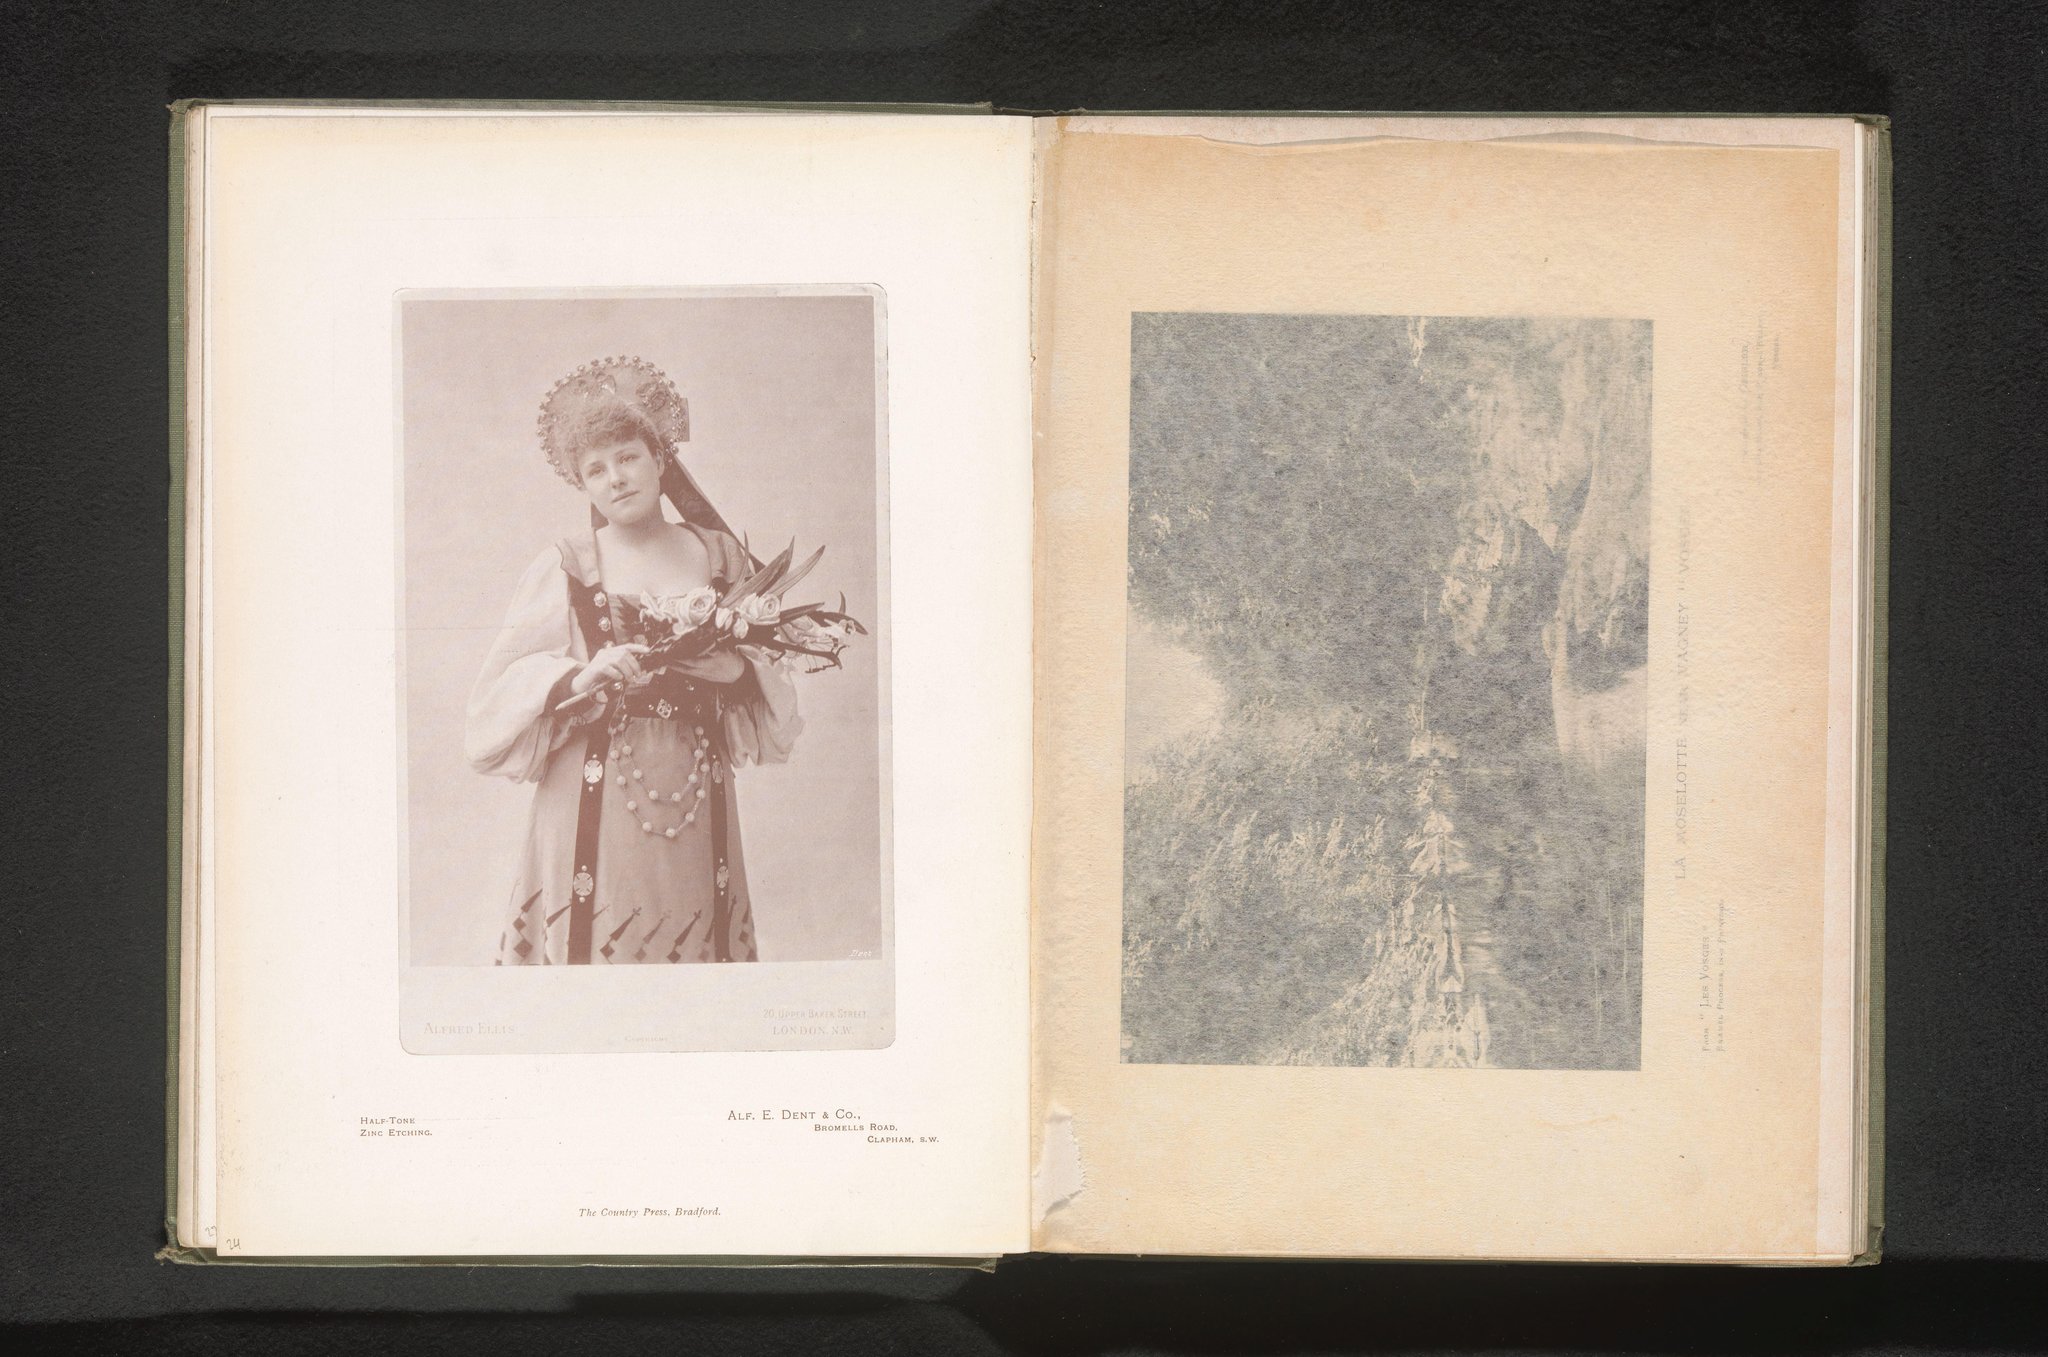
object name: reproduction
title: Reproductie van een portret van een onbekende vrouw met bloemen door Alfred Ellis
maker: alfred ellis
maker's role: fotograaf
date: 1893-1898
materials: paper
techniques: autotype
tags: historical persons - bb - woman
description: Prent op vierde ongenummerde pagina na pagina 24.